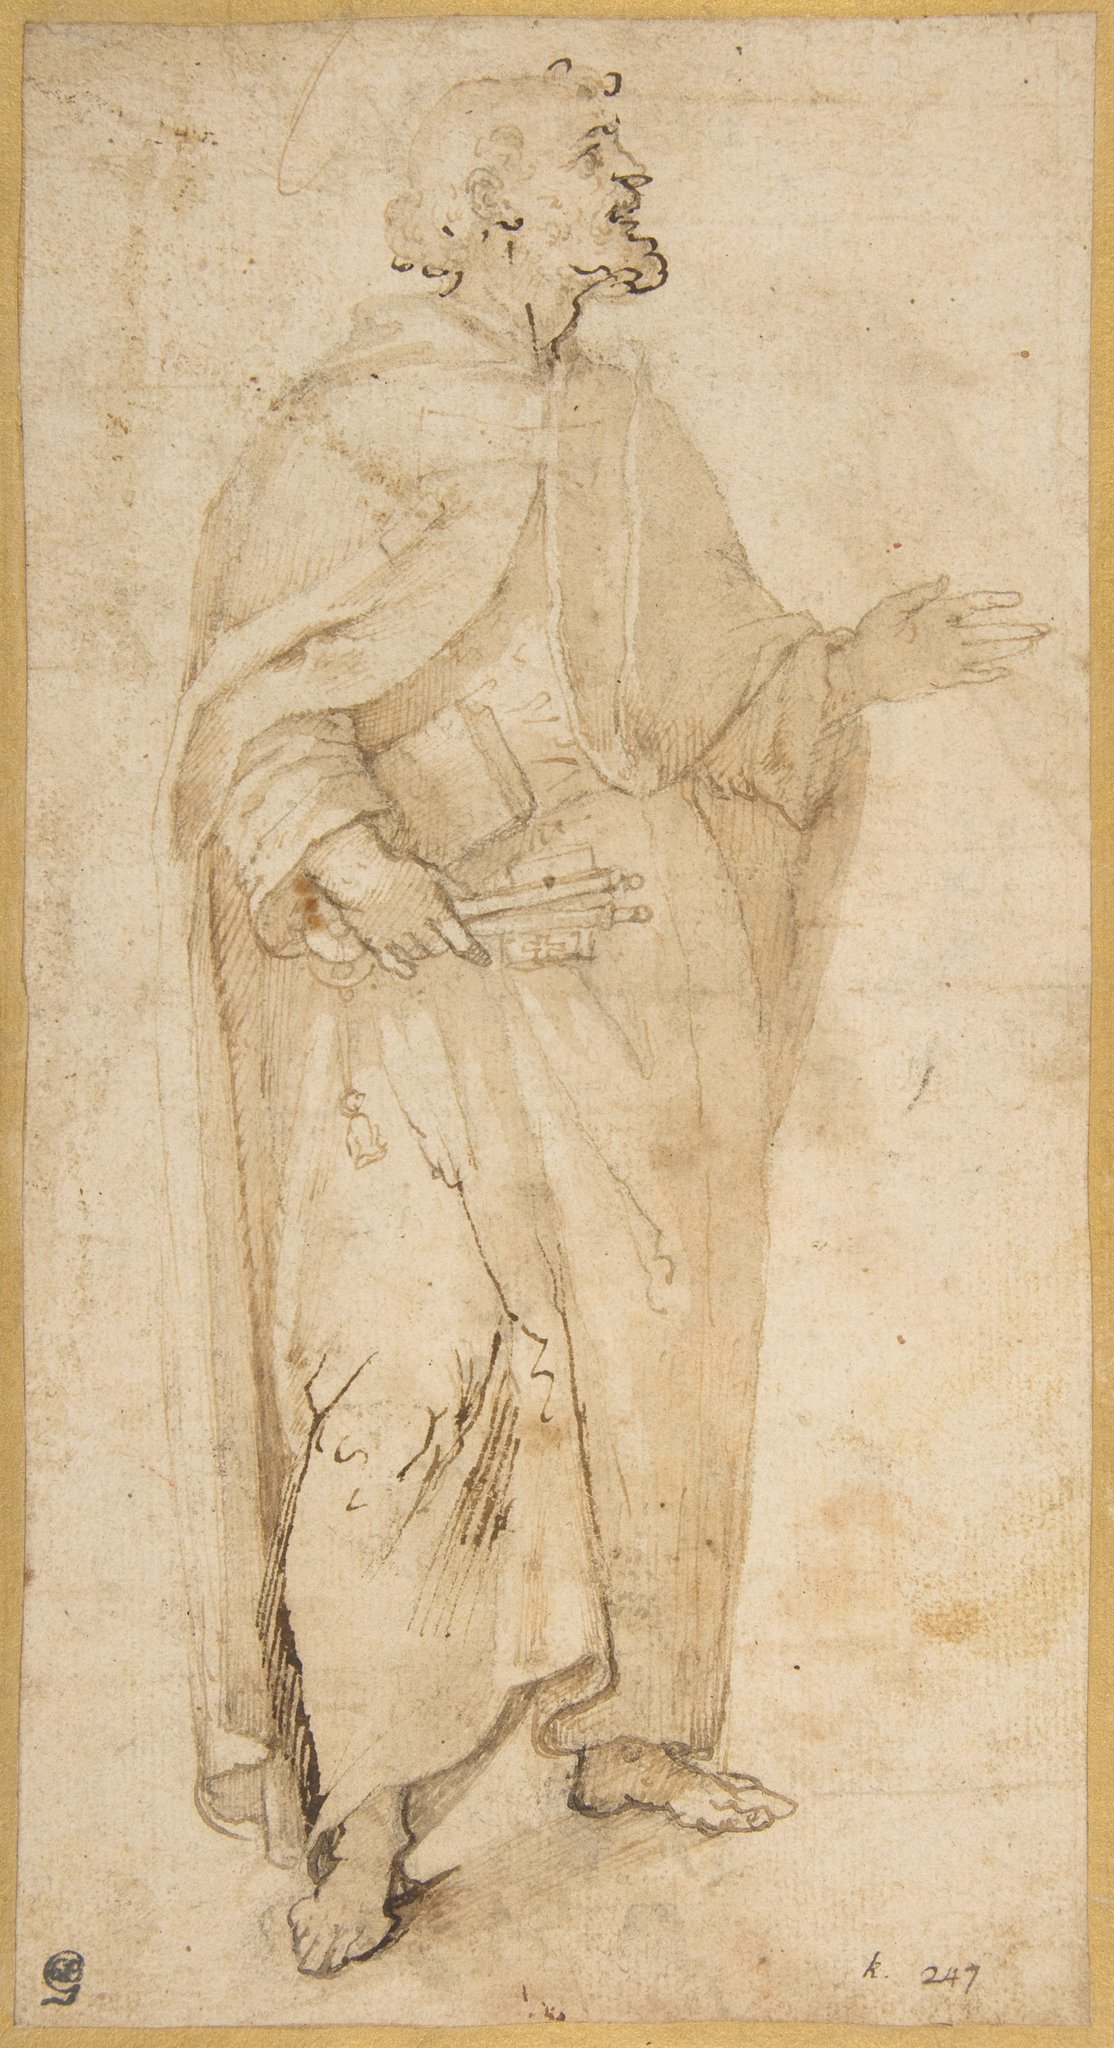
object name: drawing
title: Standing Figure of Saint Peter Holding Book and Keys.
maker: giovanni de' vecchi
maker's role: artist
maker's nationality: italian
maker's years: 1536-1615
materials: chalk, ink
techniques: brush, pen, wash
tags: books,saint peter,keys